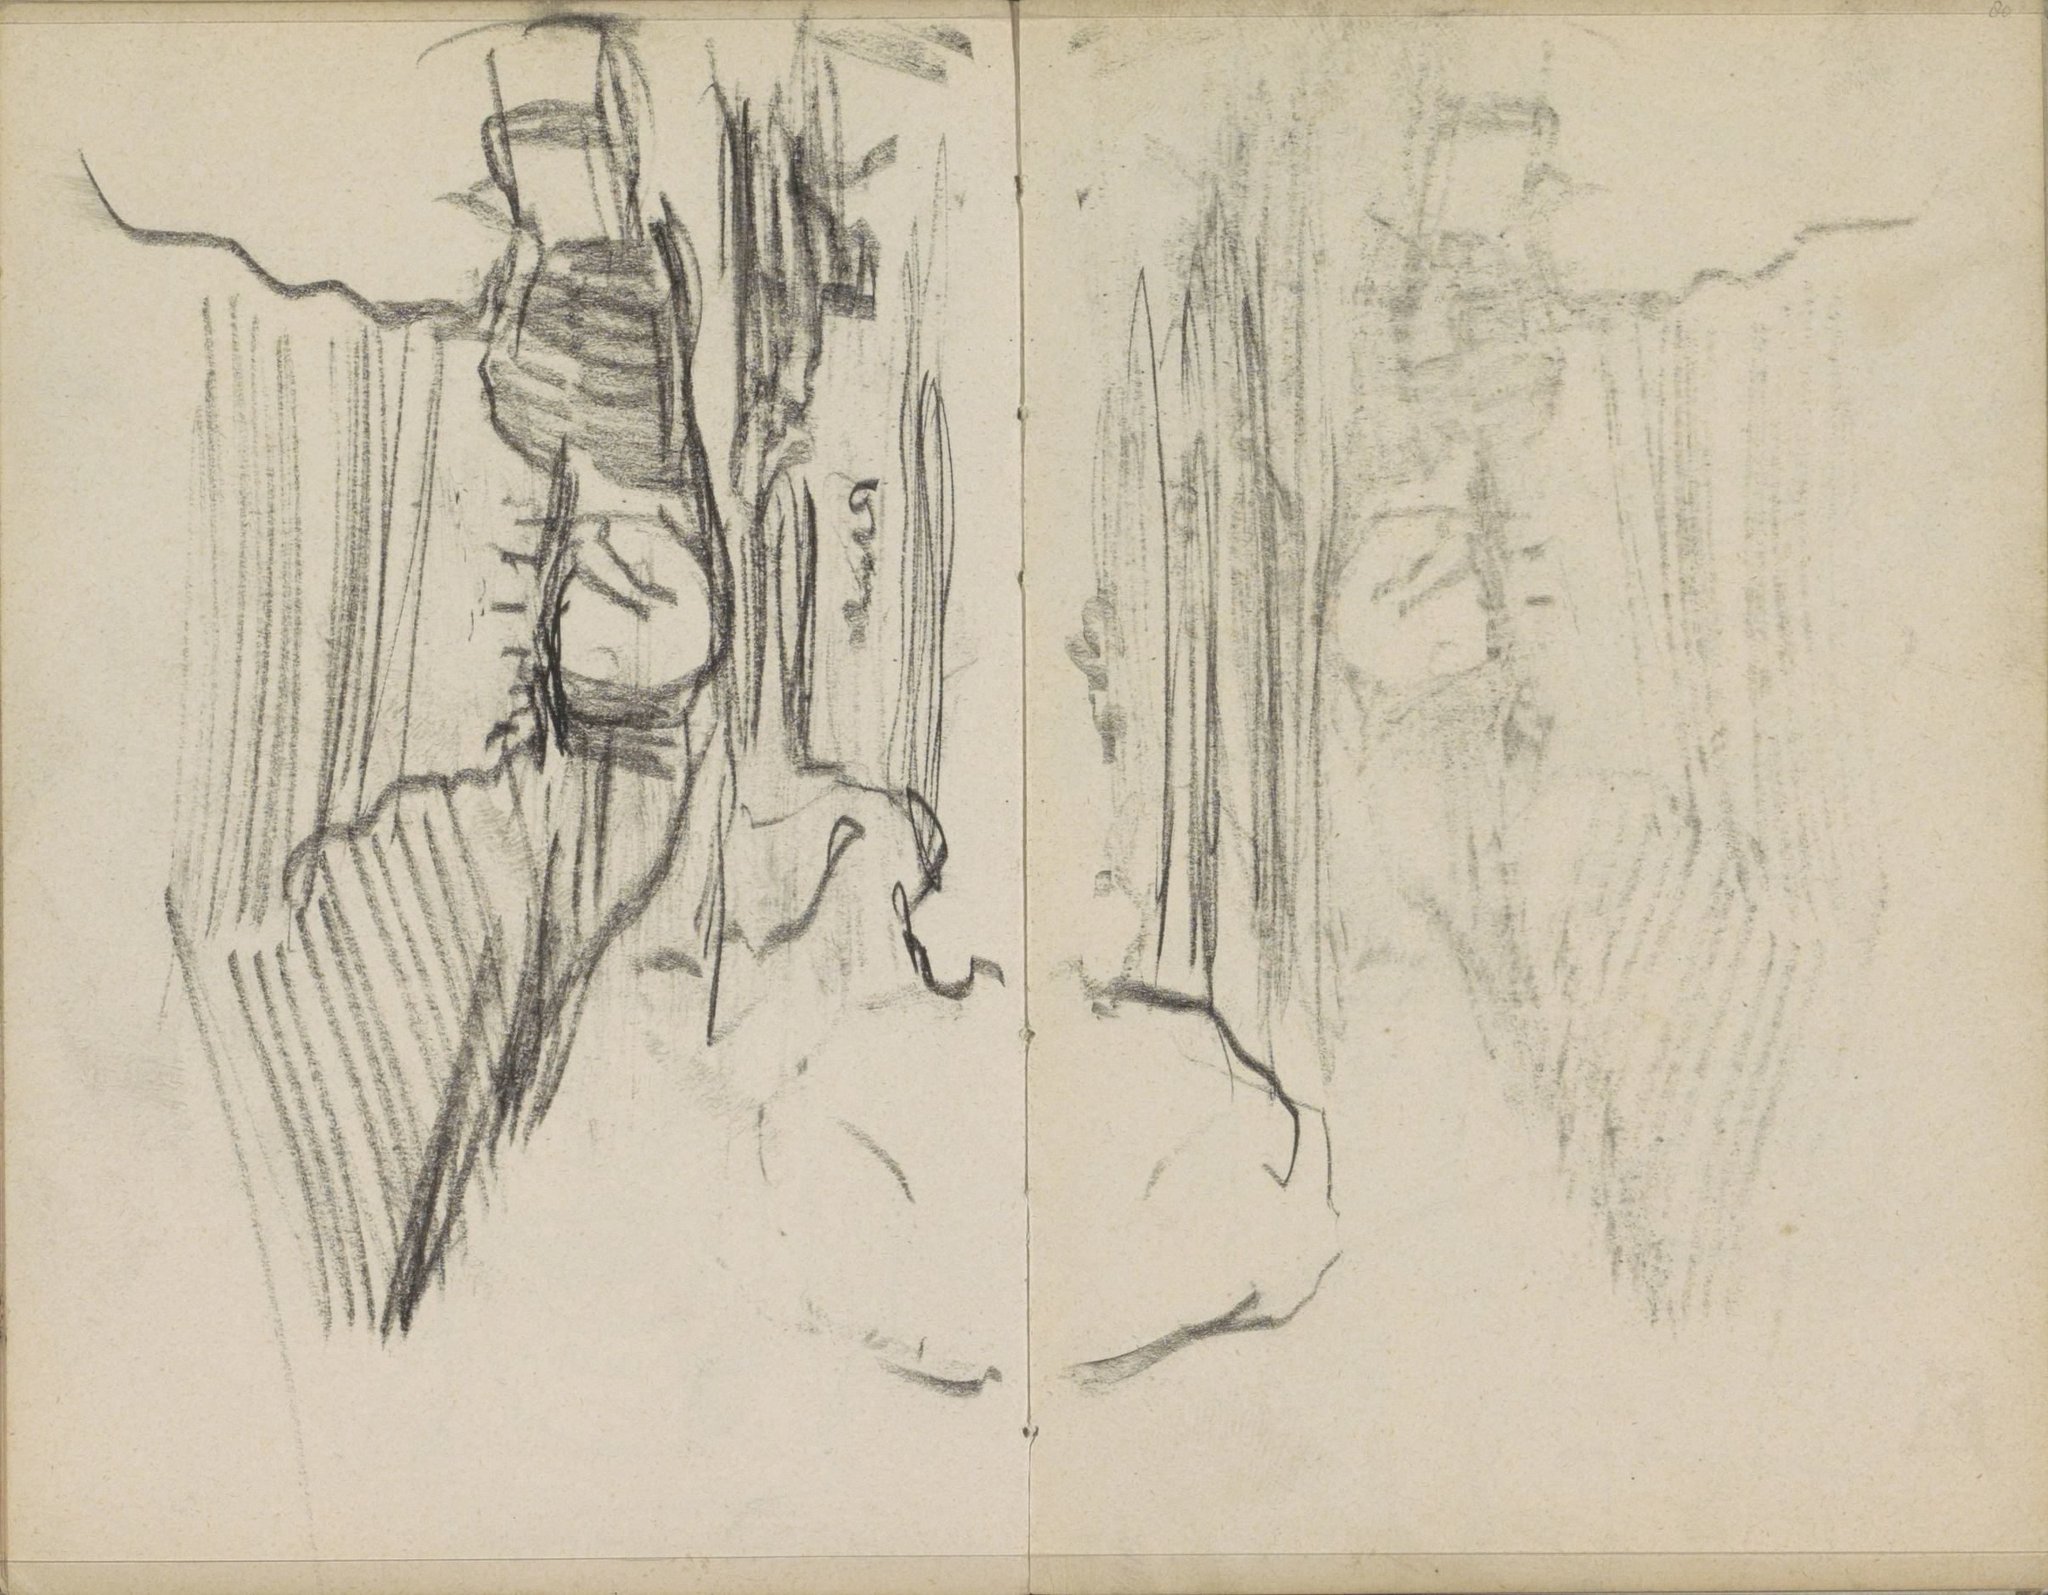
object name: sketchbook leaf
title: Brug met wolkenlucht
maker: george hendrik breitner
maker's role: draughtsman, painter, print maker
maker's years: 1857-1923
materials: chalk, paper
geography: amsterdam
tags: clouds, bridge in city across river, canal, etc.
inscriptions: kleurnotitie, handgeschreven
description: Pagina 79 en pagina 80 uit een schetsboek met 46 bladen.